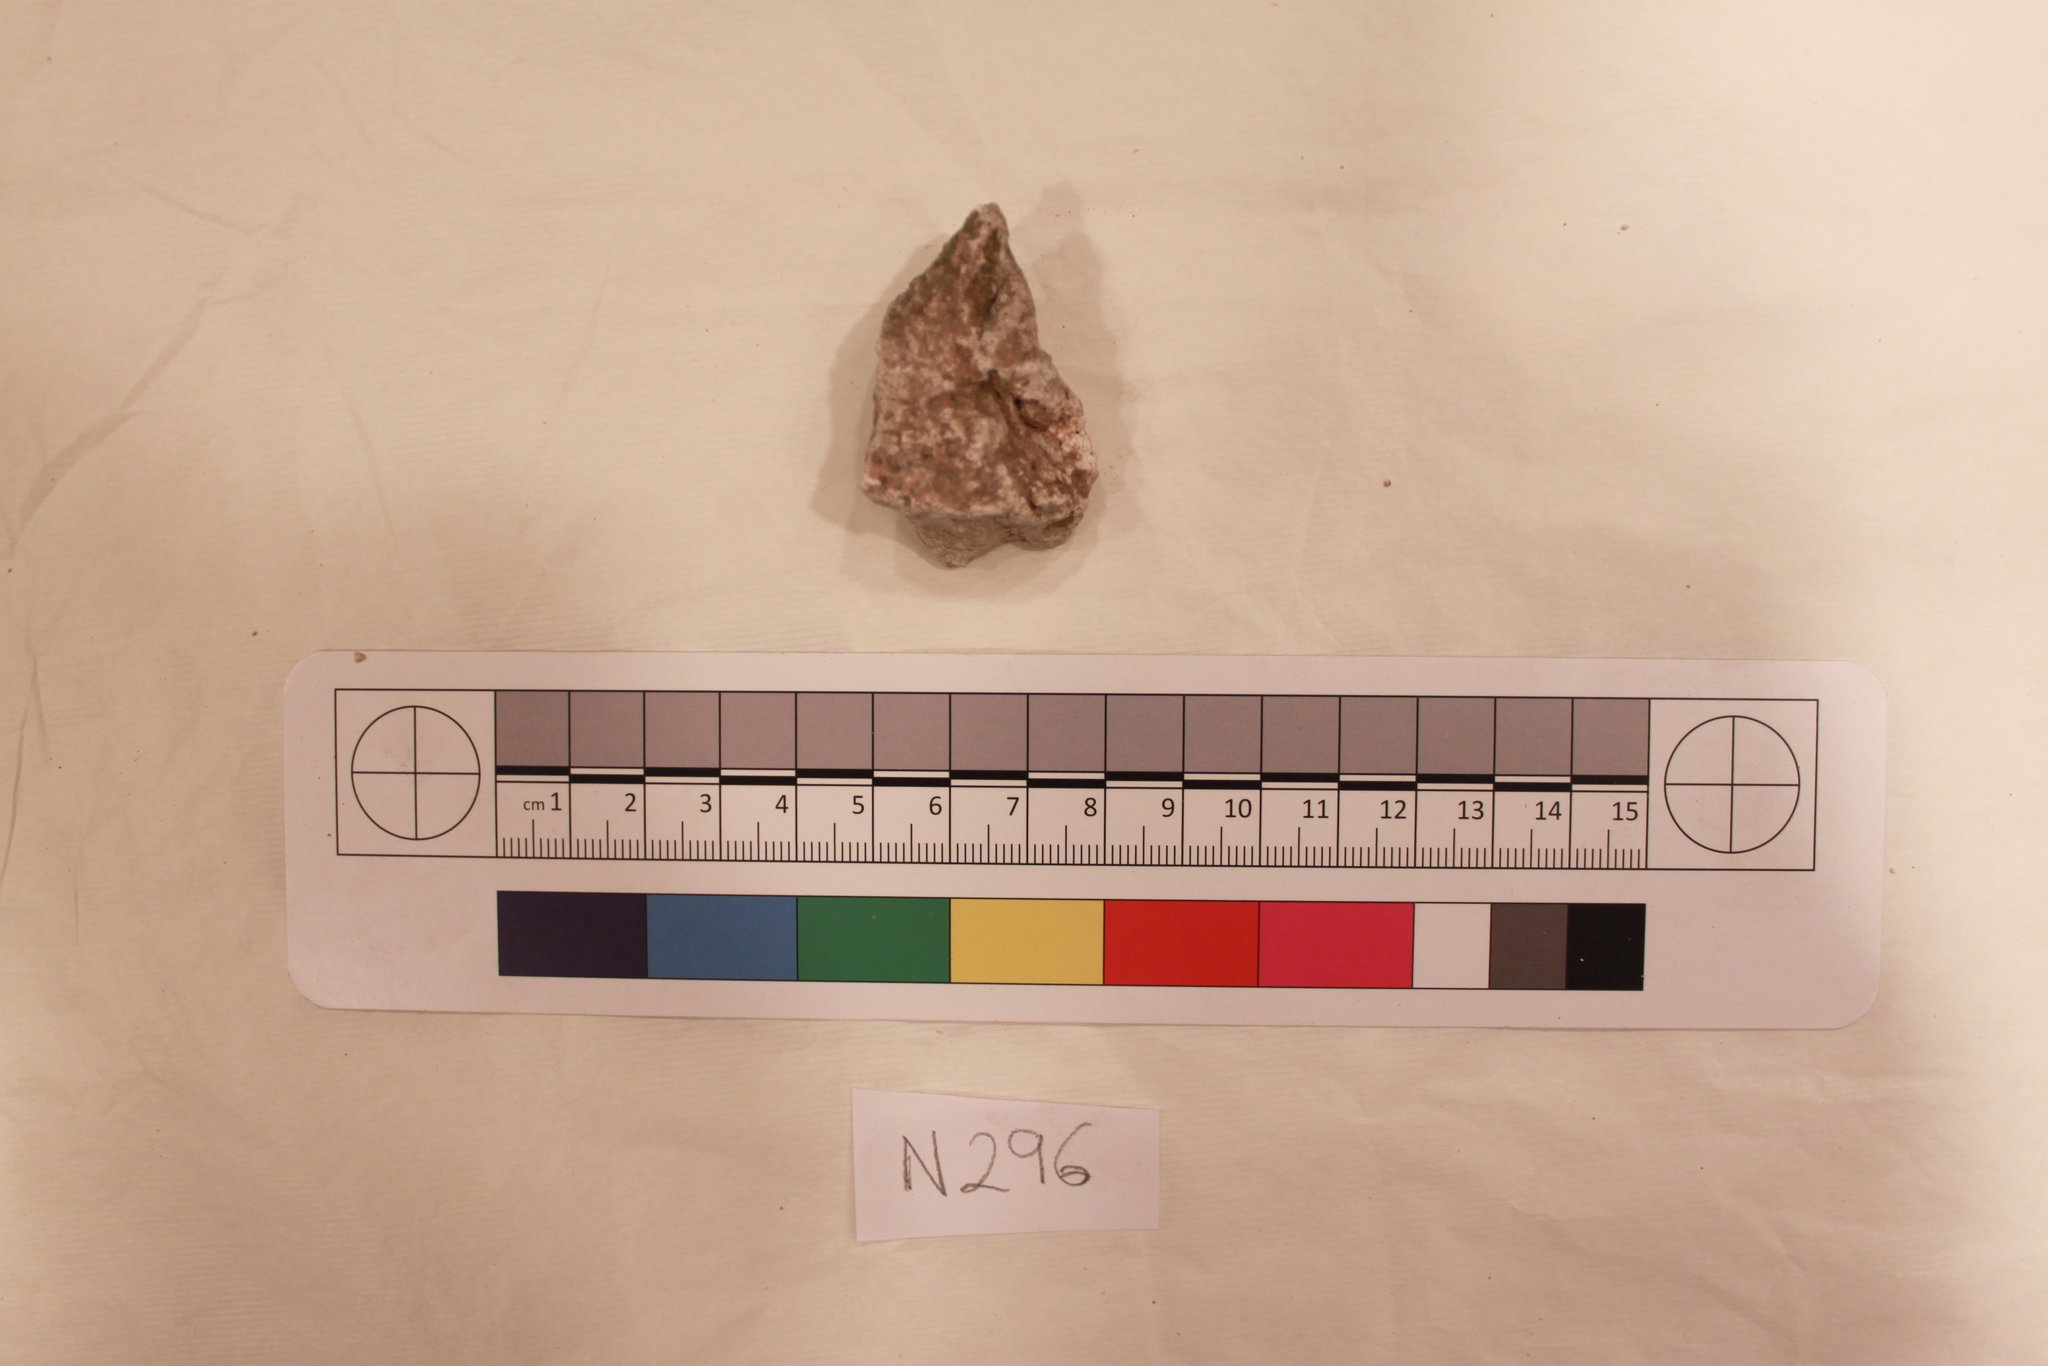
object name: fragment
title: Stucco Fragment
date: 701-1200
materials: plaster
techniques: carving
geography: iran